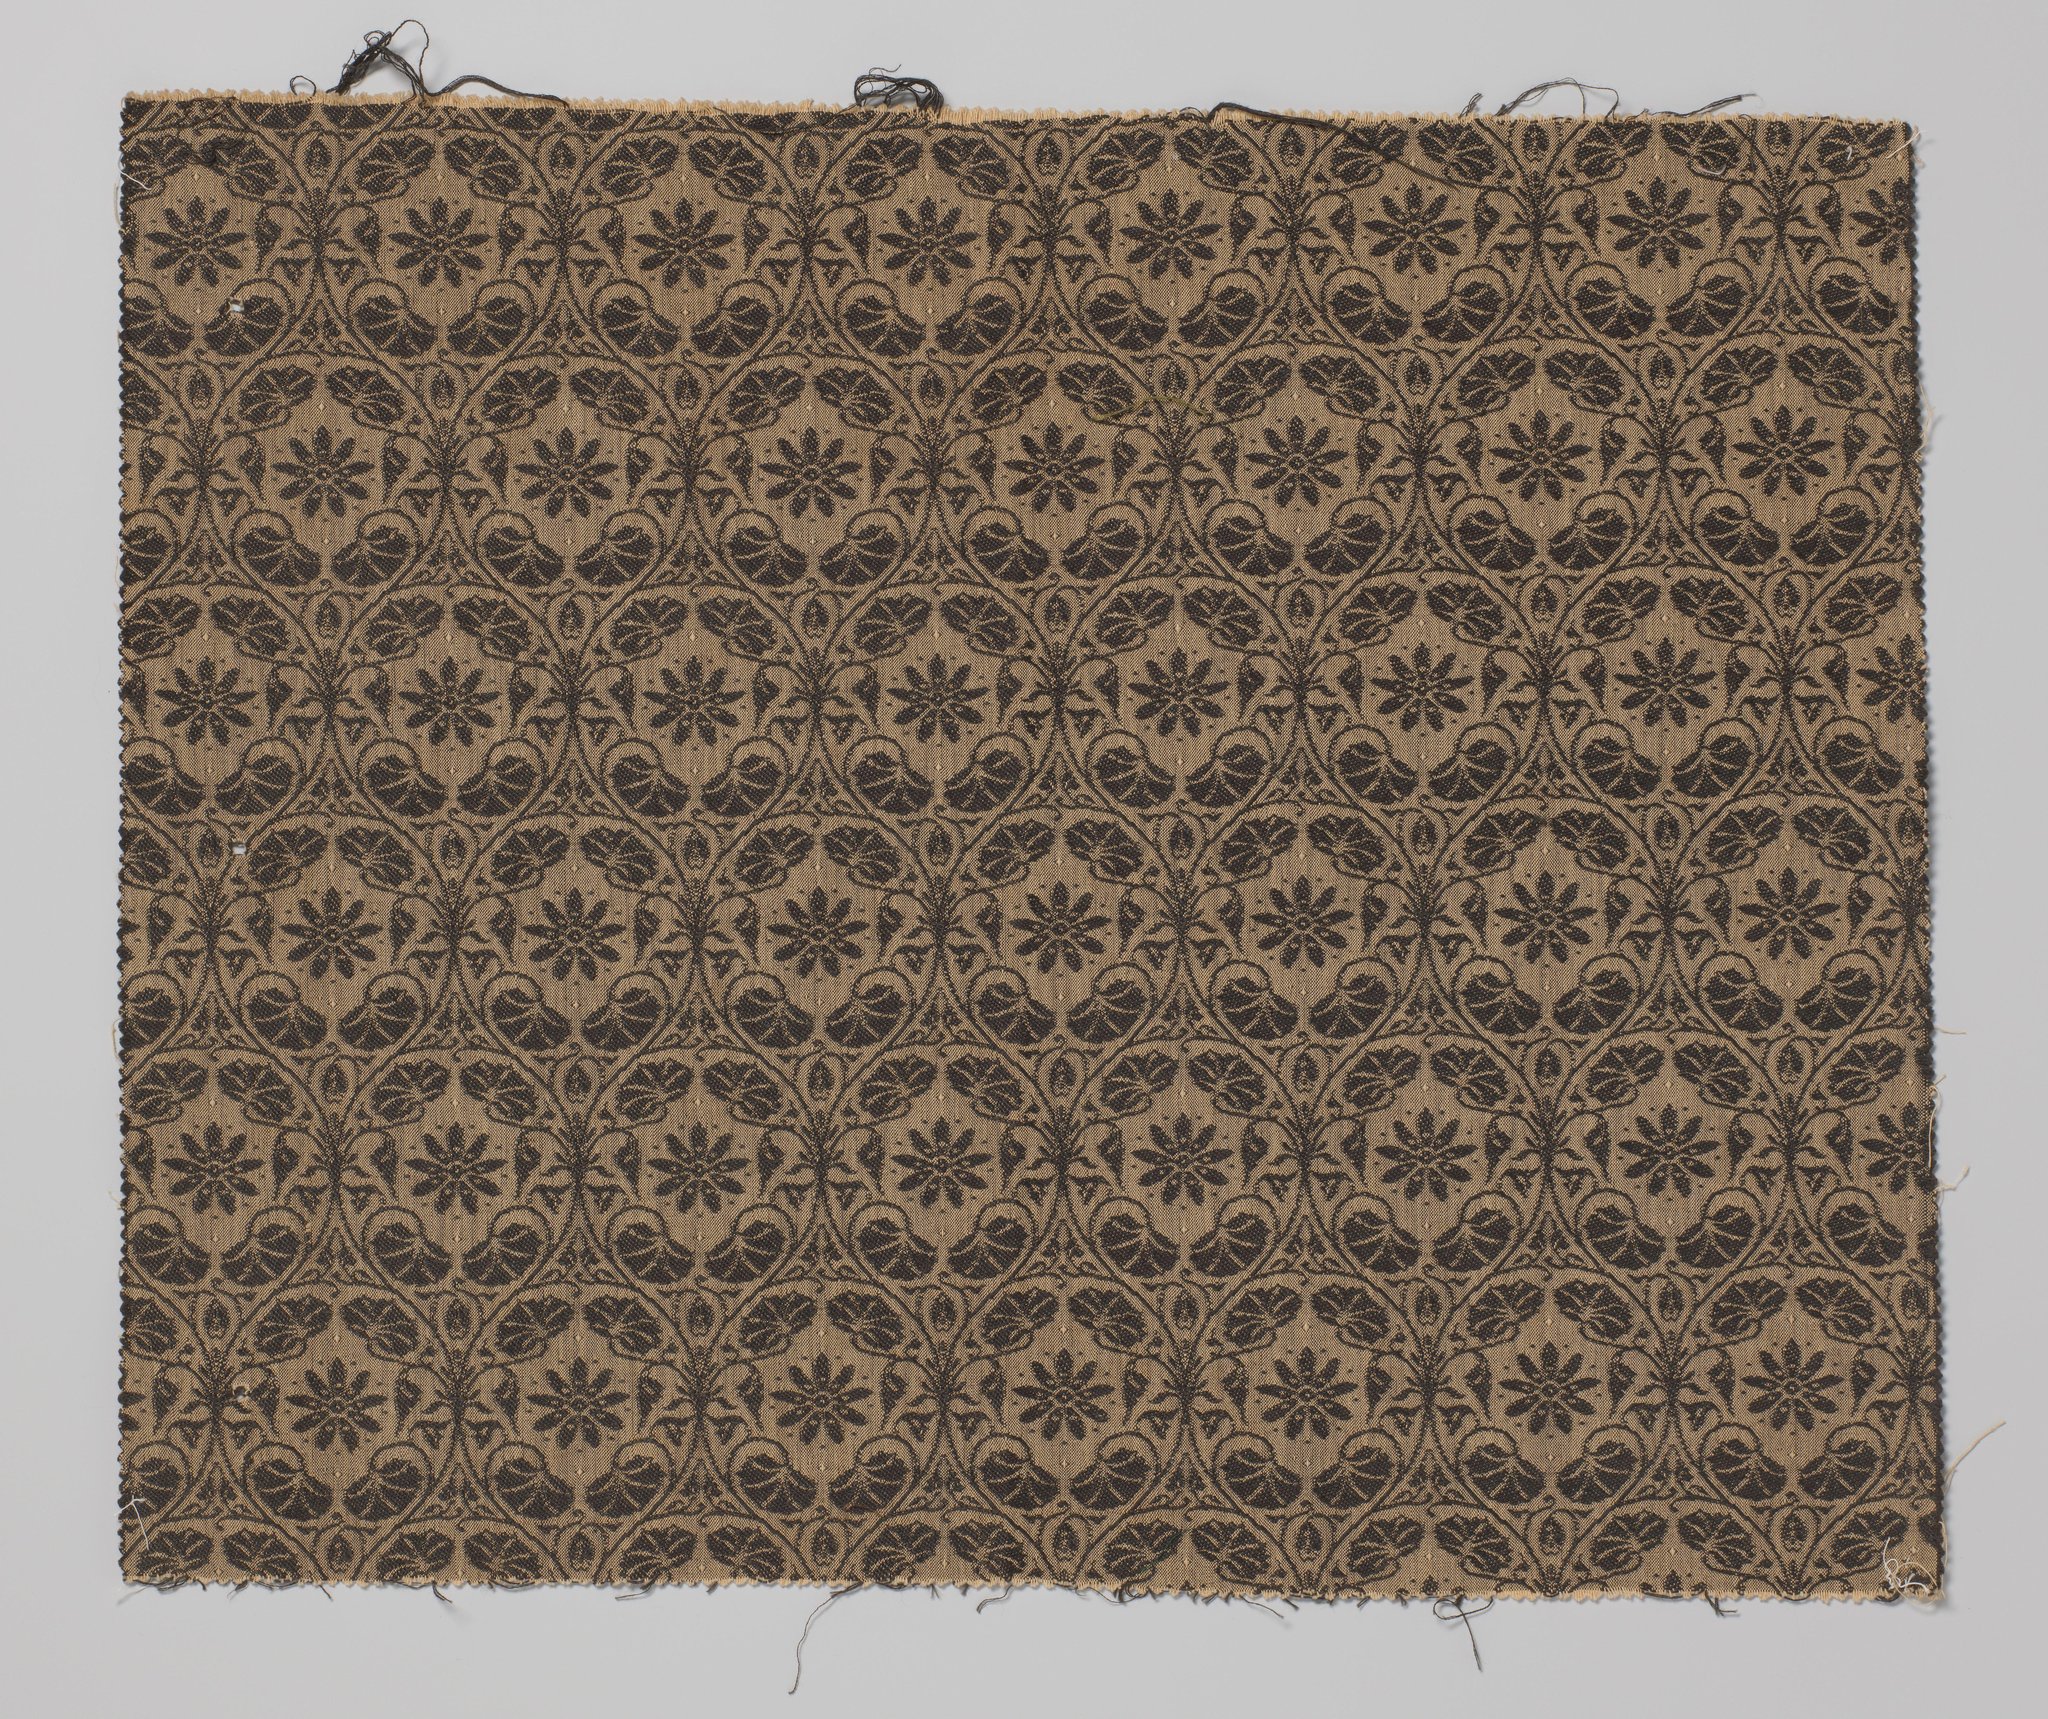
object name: upholstered wall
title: Fragment bespanningsstof met bloem binnen spitsovalen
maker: theo nieuwenhuis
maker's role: designer, draughtsman, print maker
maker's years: 1866-1951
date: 1900-1925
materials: cotton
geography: netherlands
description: Fragment bespanningsstof met bloem binnen spitsovalen. Zwarte inslag op beige ketting.